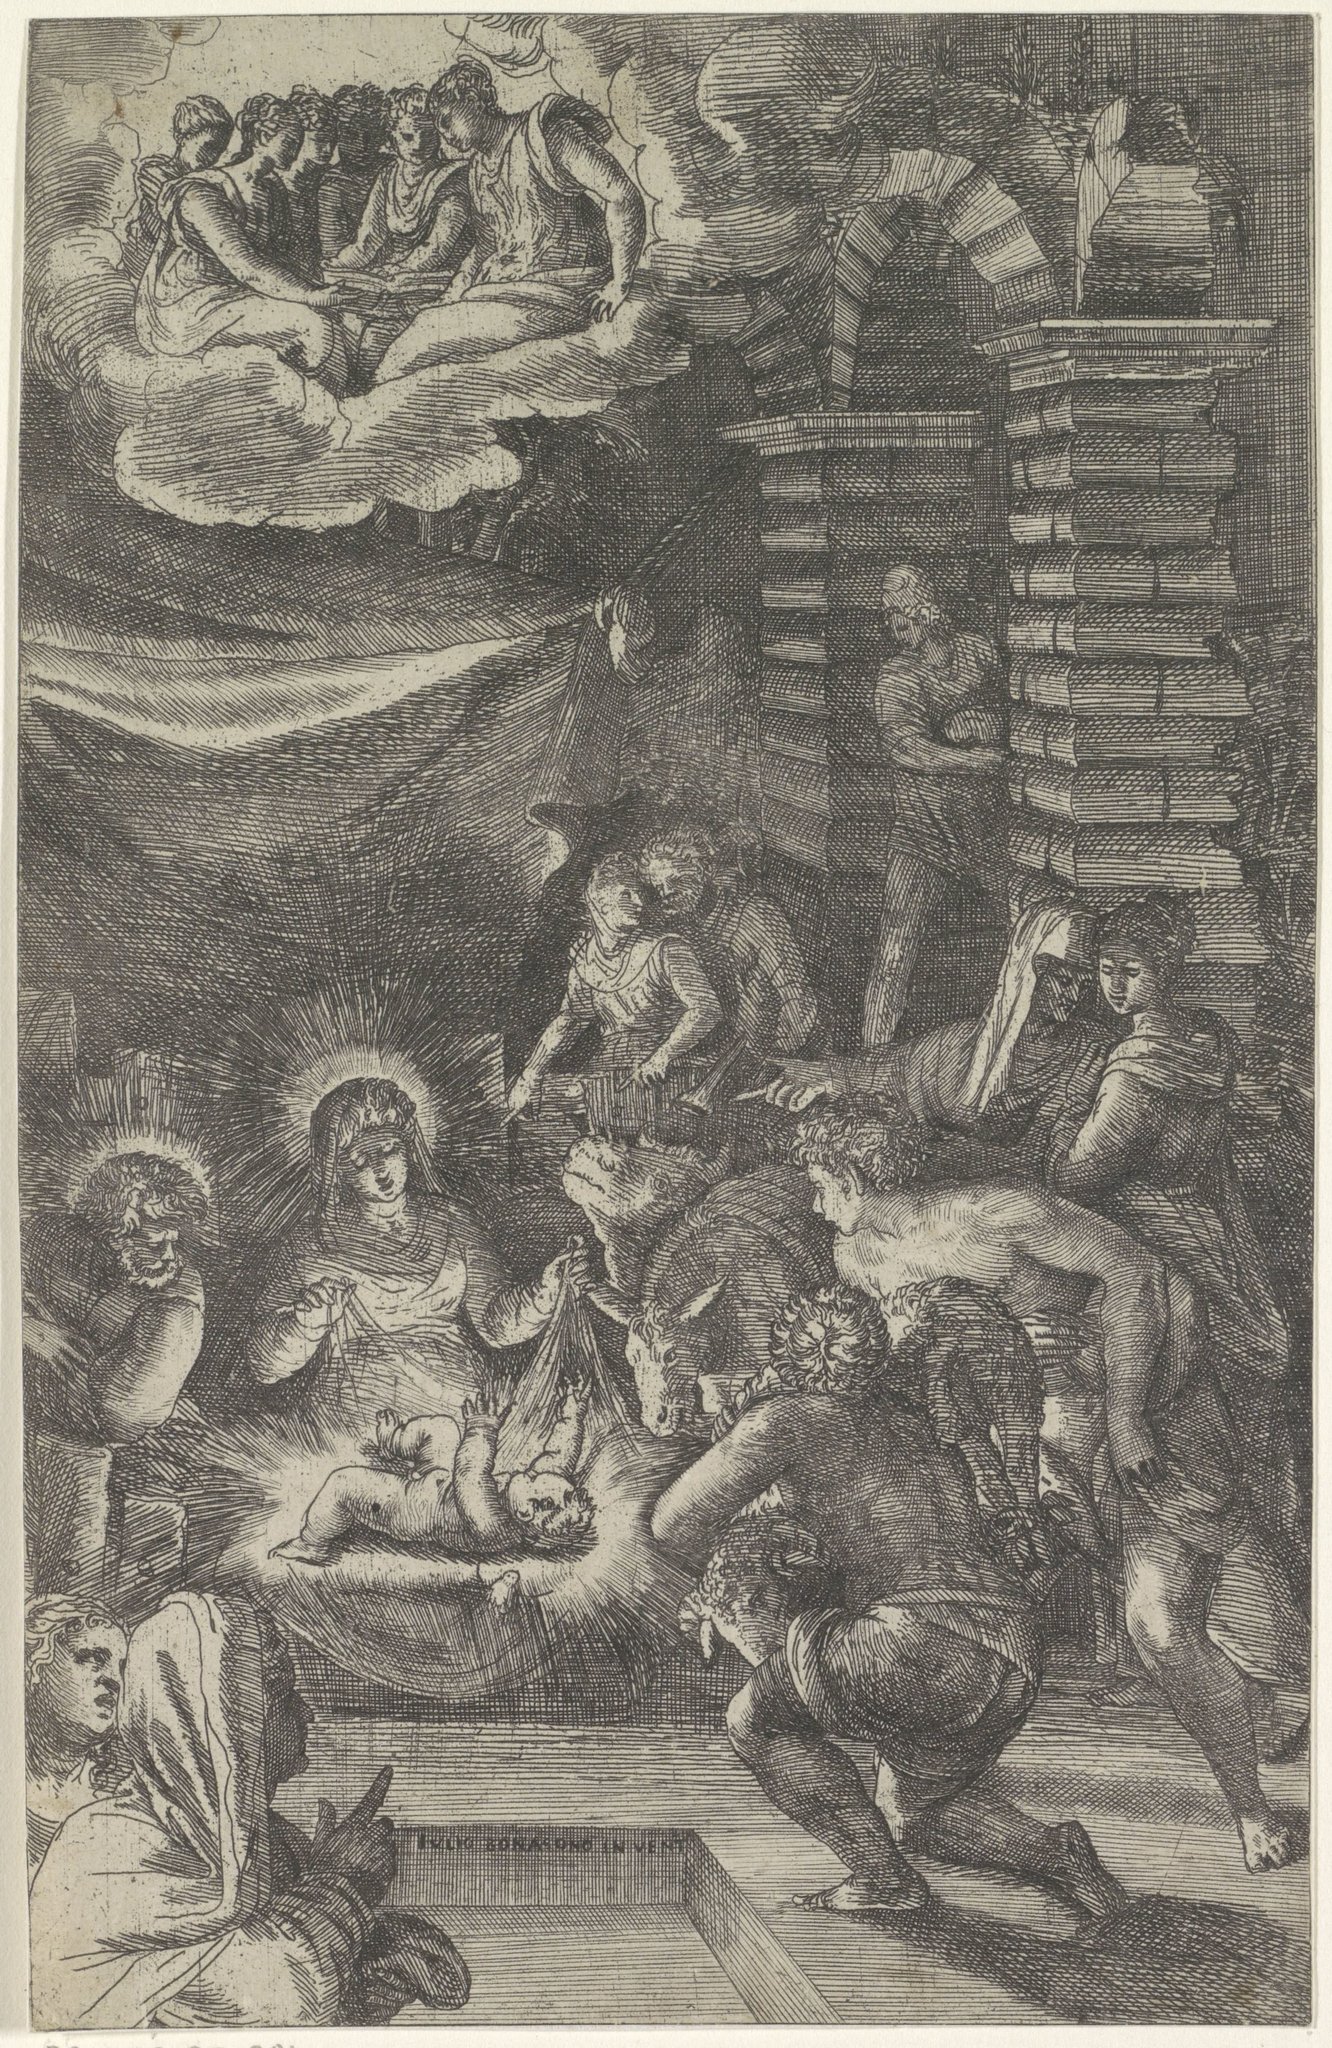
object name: print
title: Aanbidding door de herders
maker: giulio bonasone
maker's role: painter, print maker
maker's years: 1510-1576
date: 1501-1580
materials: paper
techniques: engraving, etching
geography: italy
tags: adoration of the christ-child by the shepherds; mary and joseph present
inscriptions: collector's mark: Lugt 240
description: De aanbidding van het Christuskind door de herders, Jozef en Maria en de os en de ezel. Op de achtergrond rechts een ruïne van een boog. Linksboven een groep zittende figuren op wolken.